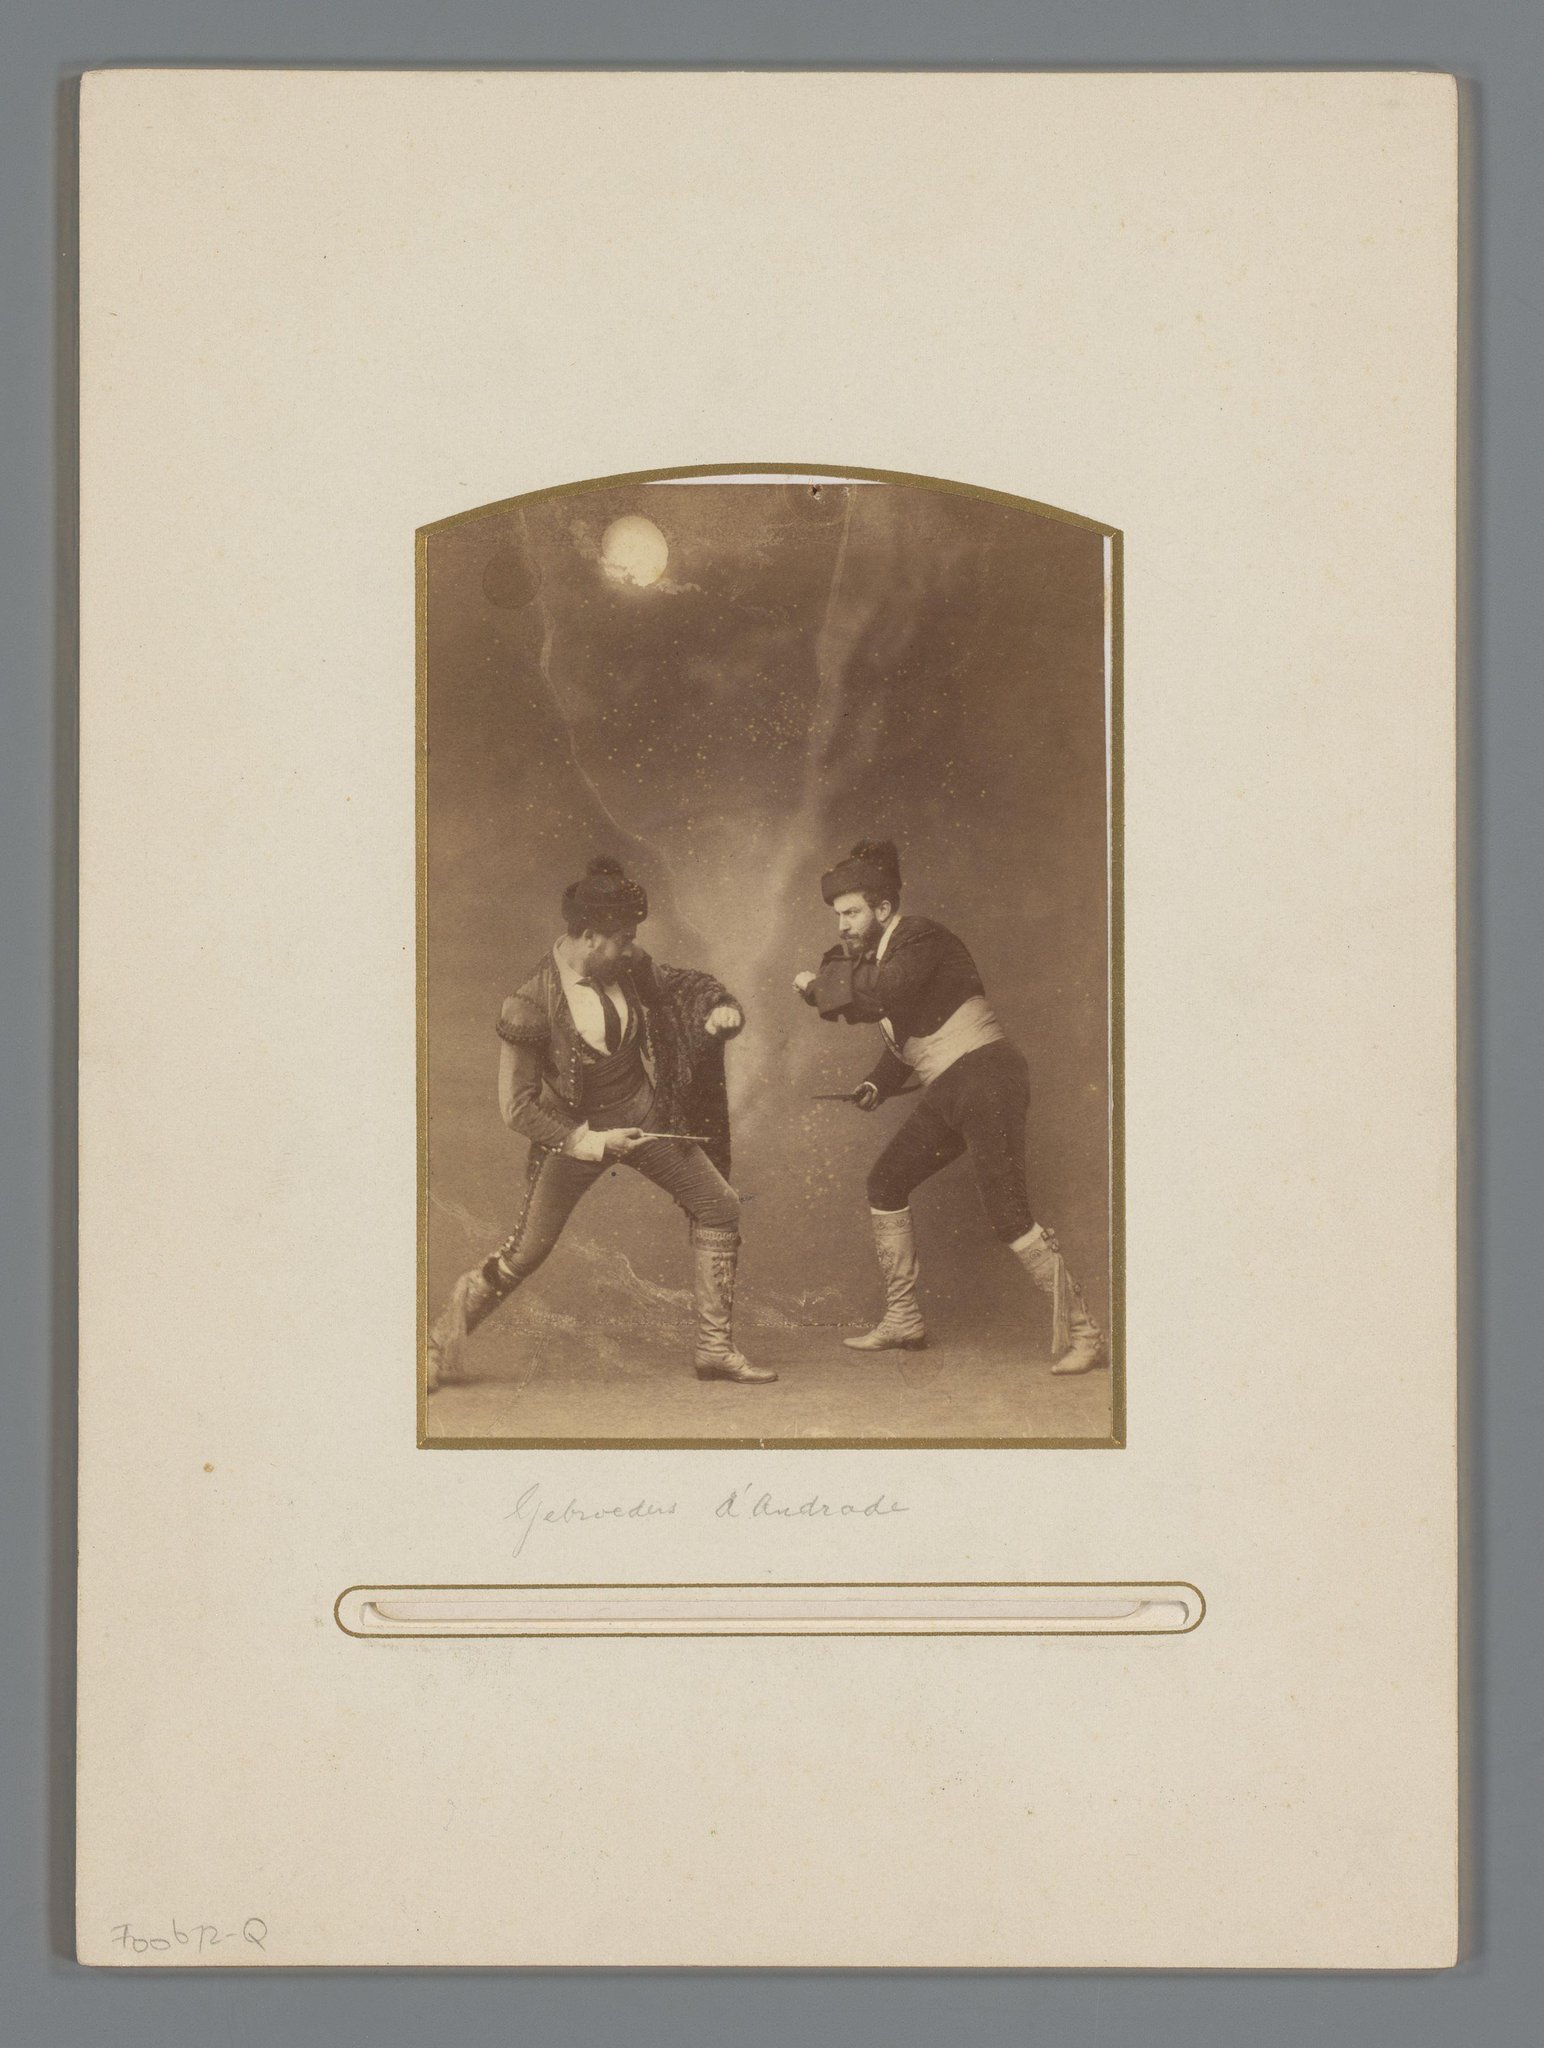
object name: photograph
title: Portret van Francisco d'Andrade en António d'Andrade, in een gevechtsscène uit Carmen van de Opera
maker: a. eichenwald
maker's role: fotograaf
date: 1870-1890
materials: cardboard, photographic support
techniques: albumen print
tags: berlin, adult man, historical persons, portrait of opera-singer, brothers (second degree family relationships)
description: Deze foto maakt deel uit van een omslag met 22 foto's.